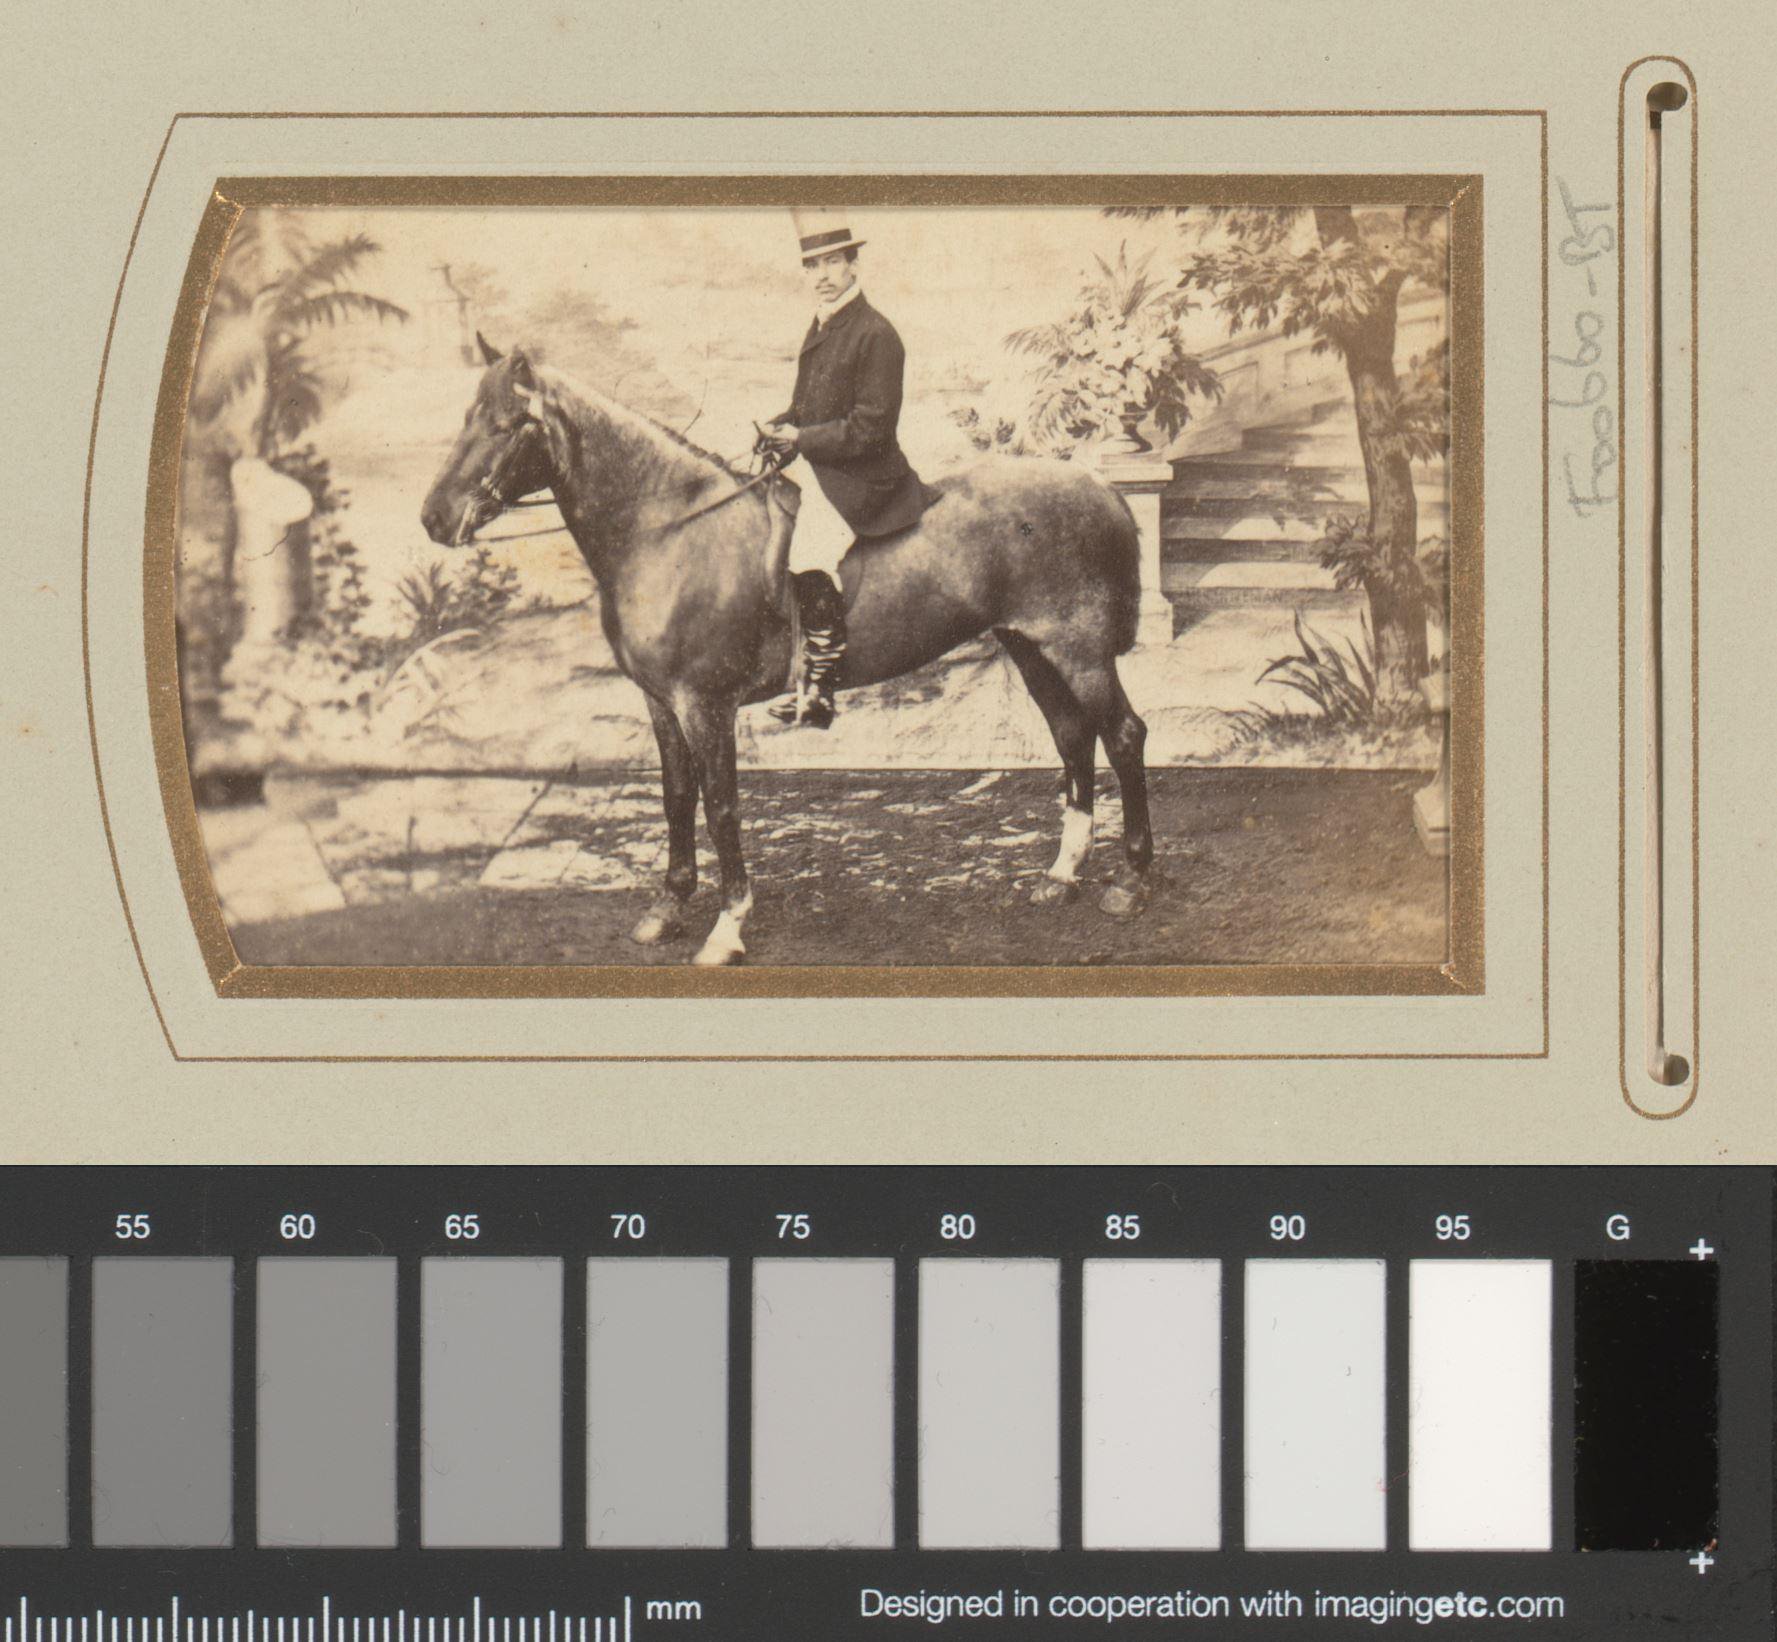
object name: carte de visite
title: Portret van een man te paard met hoge hoed, voor een achtergrond waarop een landschap is afgebeeld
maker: auguste blanche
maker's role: fotograaf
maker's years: 1818-1866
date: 1850-1900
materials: cardboard, photographic support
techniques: albumen print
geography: antwerp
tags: riding a horse, ass, or mule; rider, horseman, historical persons, horse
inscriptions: inscription: ‘Blanche/ PHOTOGRAPHE,/ Rue des Aveugles/ & Place du Musée/ ANVERS.’